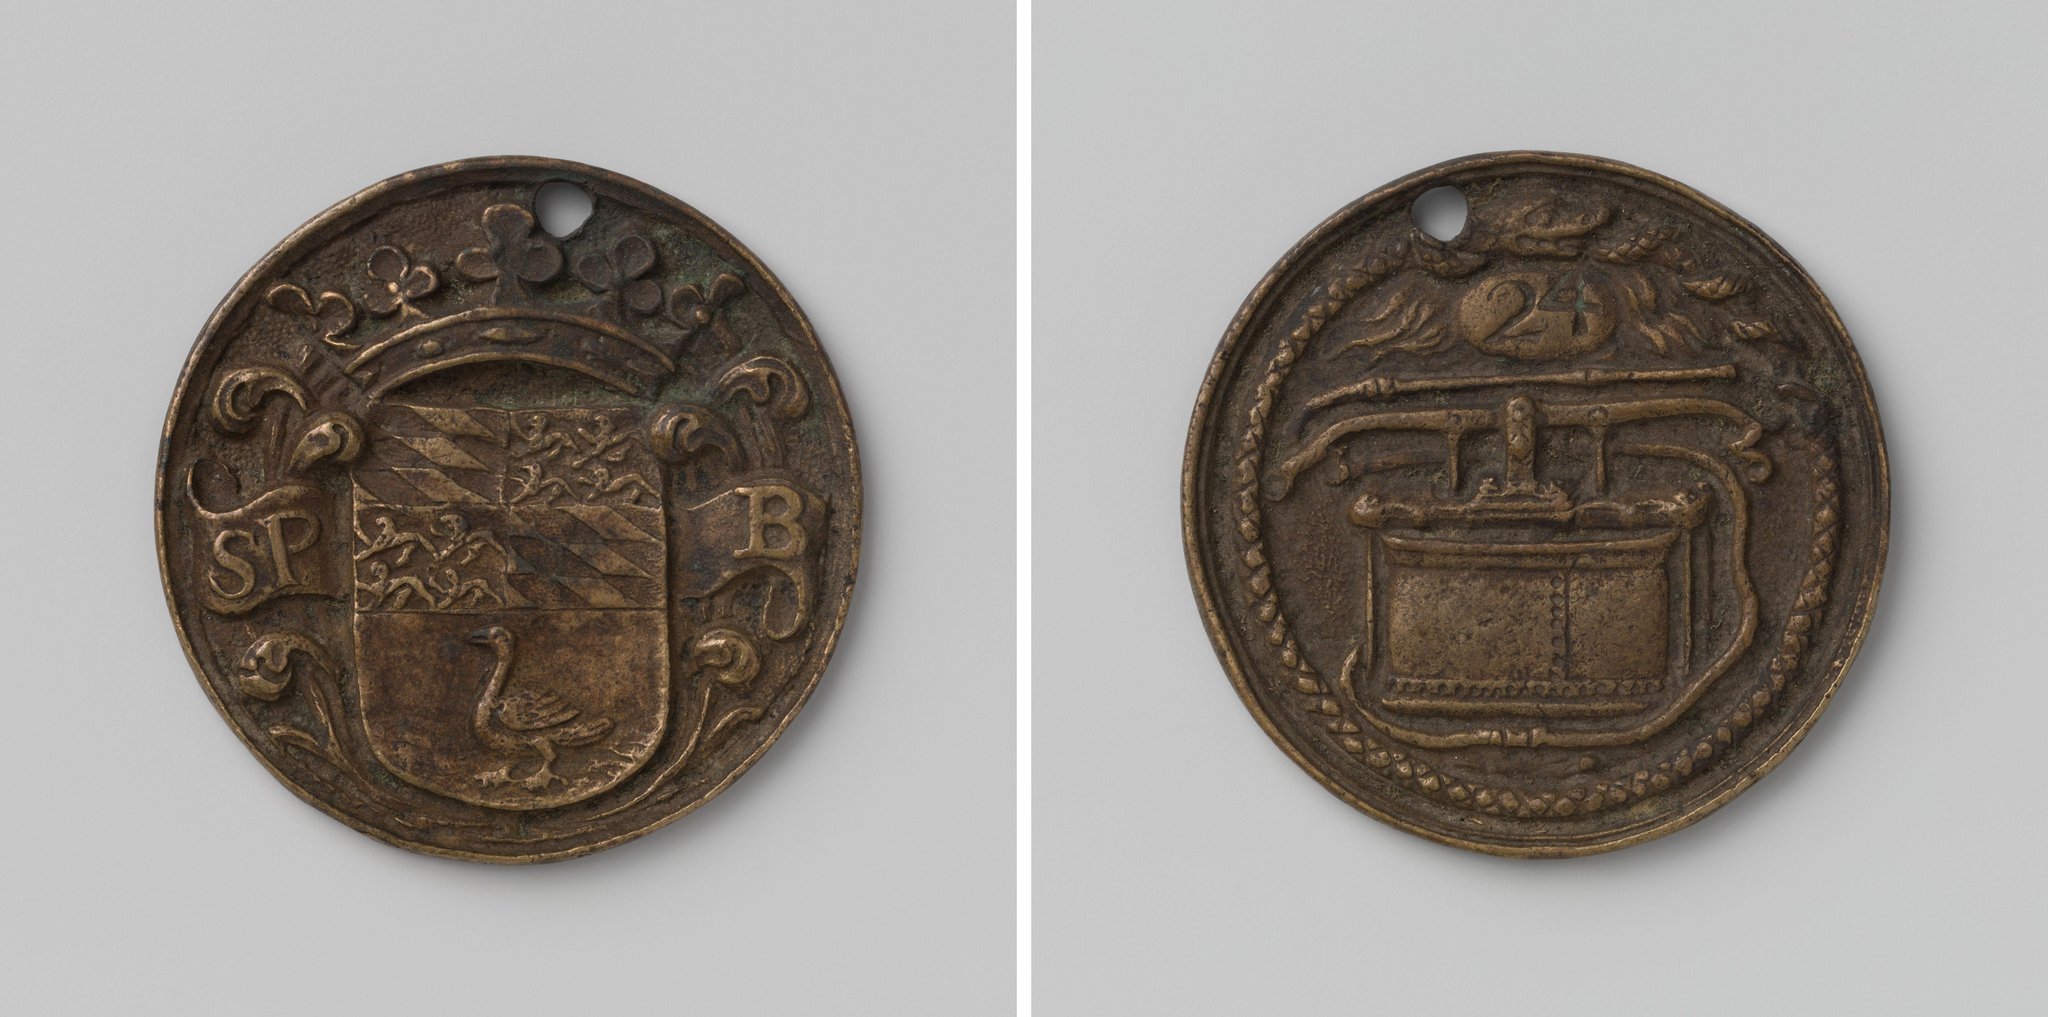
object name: medal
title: Goes, brandspuitpenning van spuit B met no. 24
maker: Anonymous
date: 1680-1800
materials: brass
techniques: casting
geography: goes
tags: goes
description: Messing penning met gat erin. Voorzijde: gekroond wapenschild; daarachter: lint met opschrift SP en B. Keerzijde: brandspuit onder cartouche met no. 24 binnen slangerond